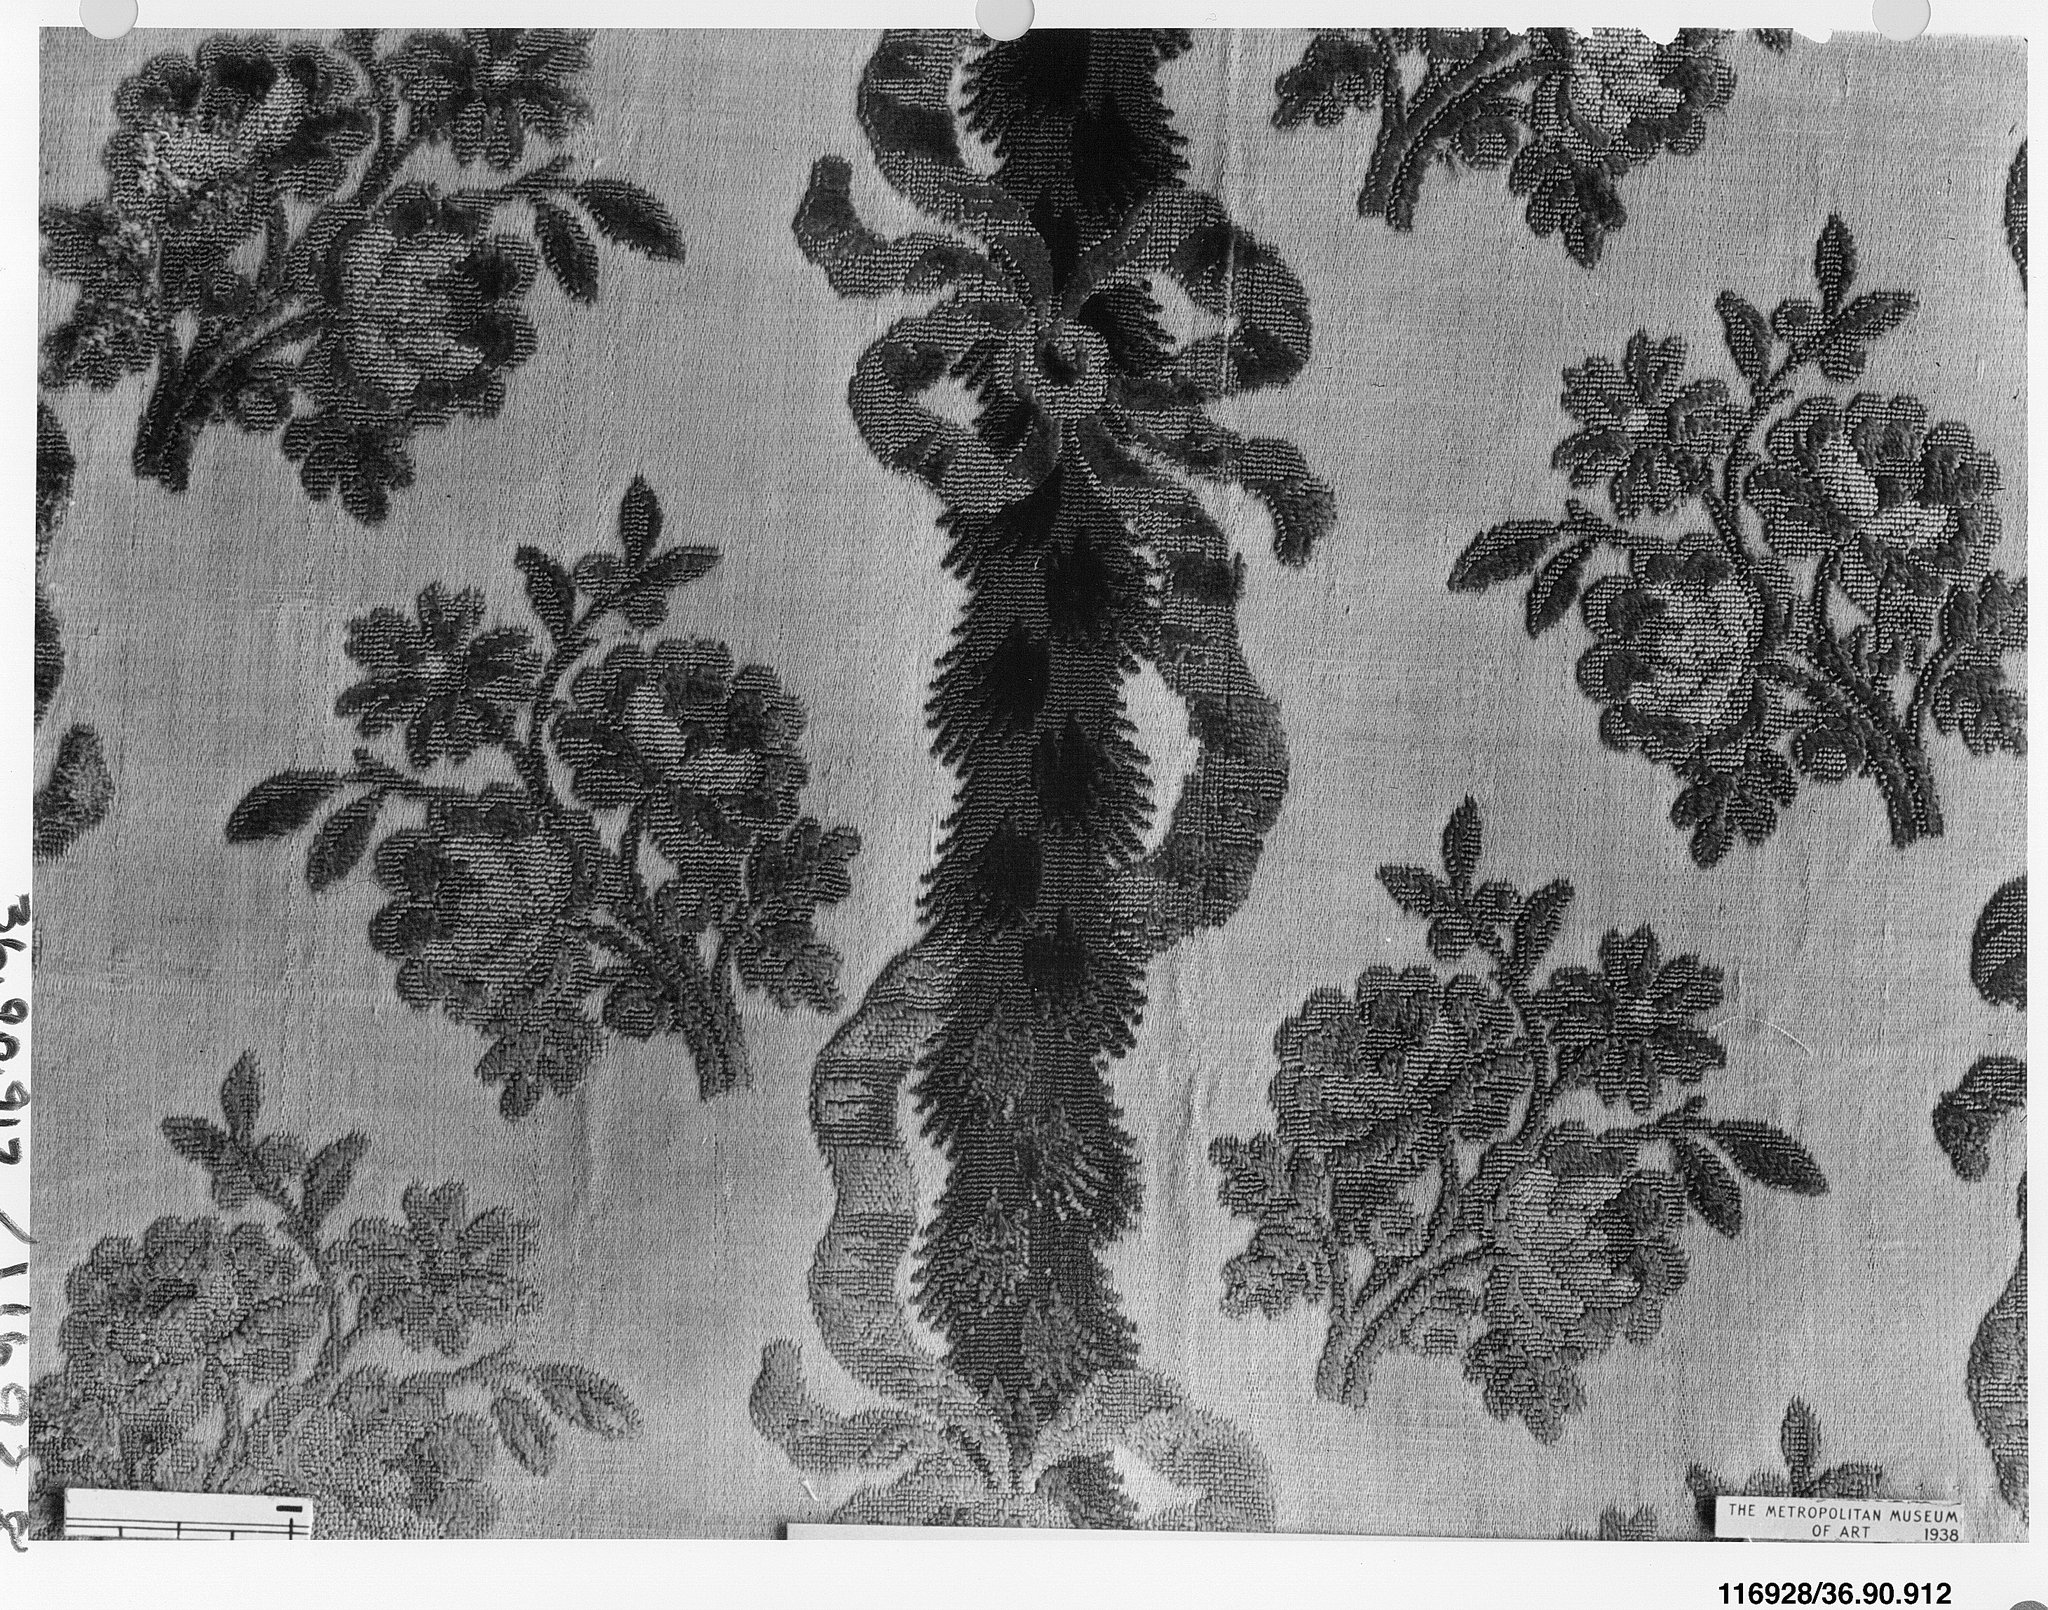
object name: piece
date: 1760-1770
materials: silk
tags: flowers,leaves